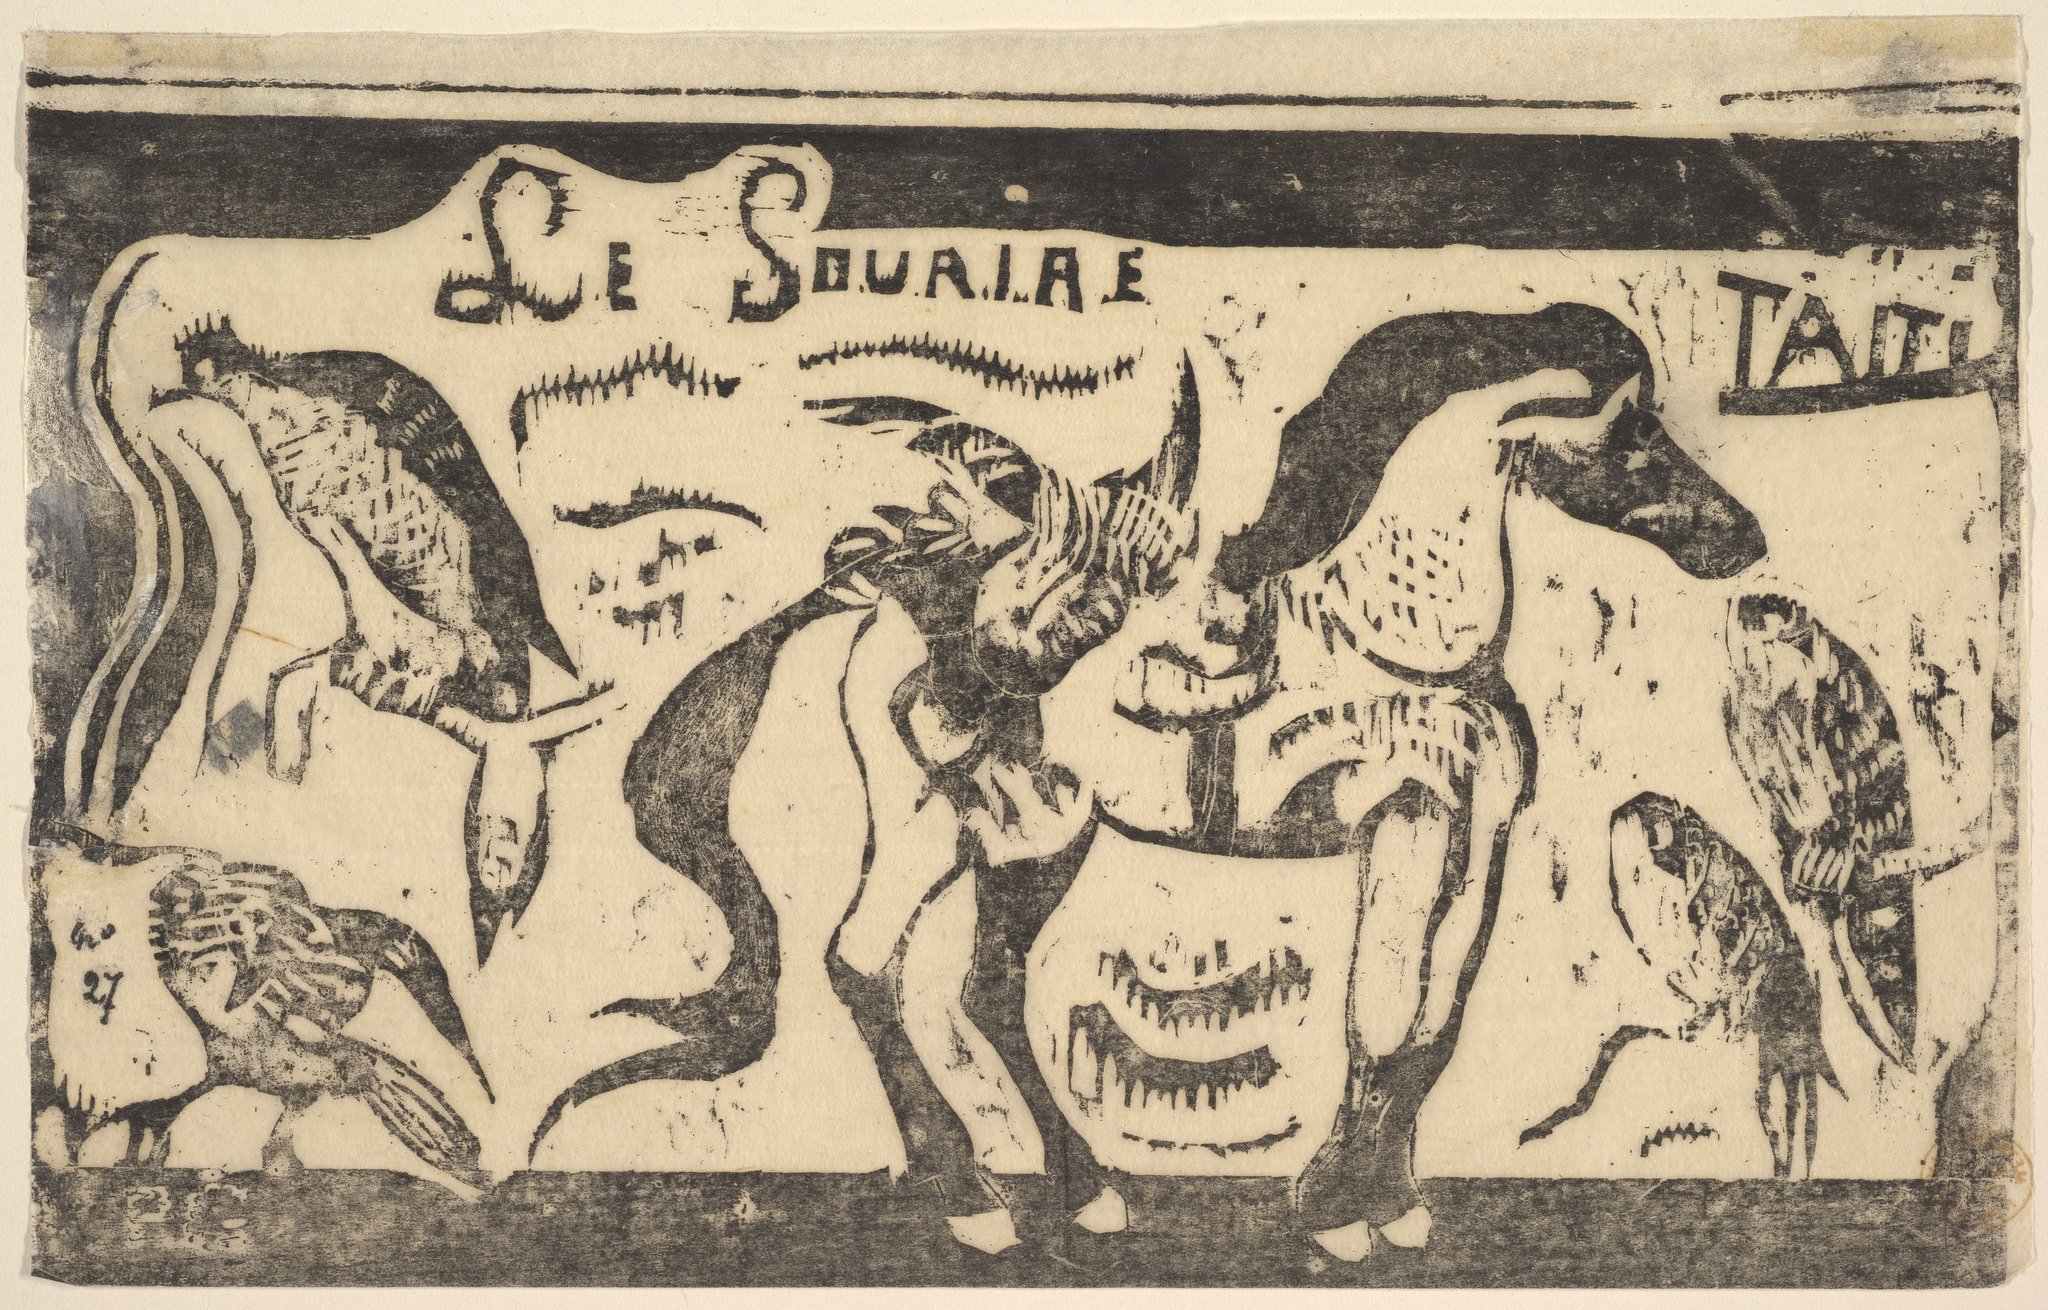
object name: print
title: Le Sourire;Taiti (Smile; Tahiti)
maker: paul gauguin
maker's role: artist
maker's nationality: french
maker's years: 1848-1903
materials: paper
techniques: woodcut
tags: birds,horses